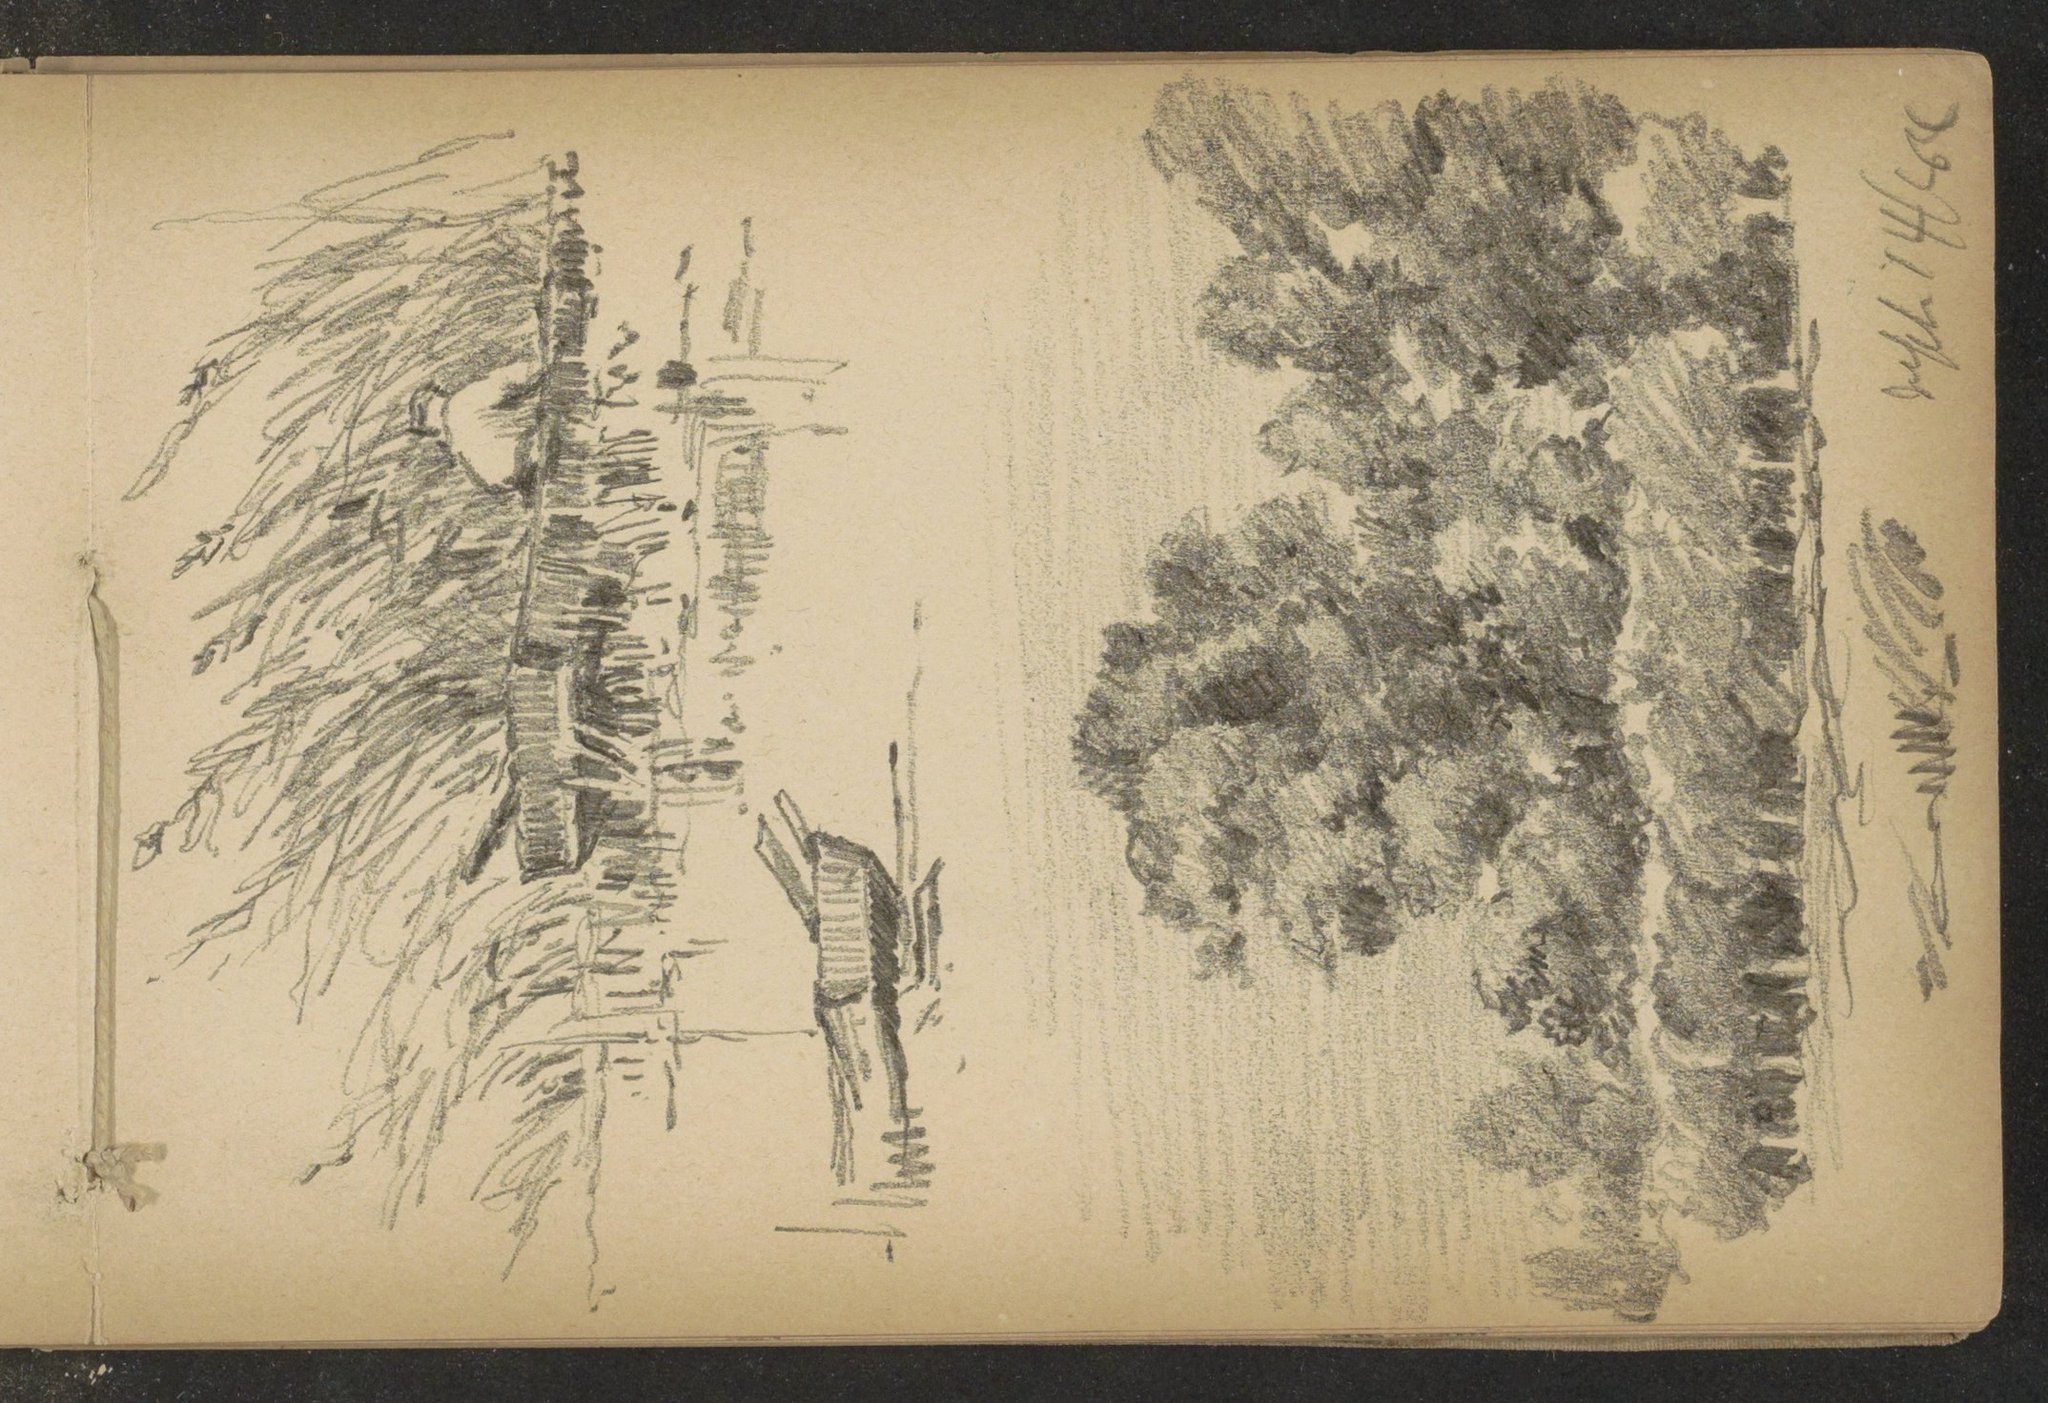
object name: sketchbook leaf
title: Zittende man aan een waterkant, een roeiboot en een landschap met bomen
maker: alexander shilling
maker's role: draughtsman, print maker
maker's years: 1859-1937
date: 1809-1888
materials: paper, pencil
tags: trees, rowing-boat, canoe, etc., landscapes with waters, waterscapes, seascapes (in the temperate zone) (+ landscape with figures, staffage)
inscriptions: date: ‘sept 14/88’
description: Blad 18 recto uit een schetsboek met 34 bladen.